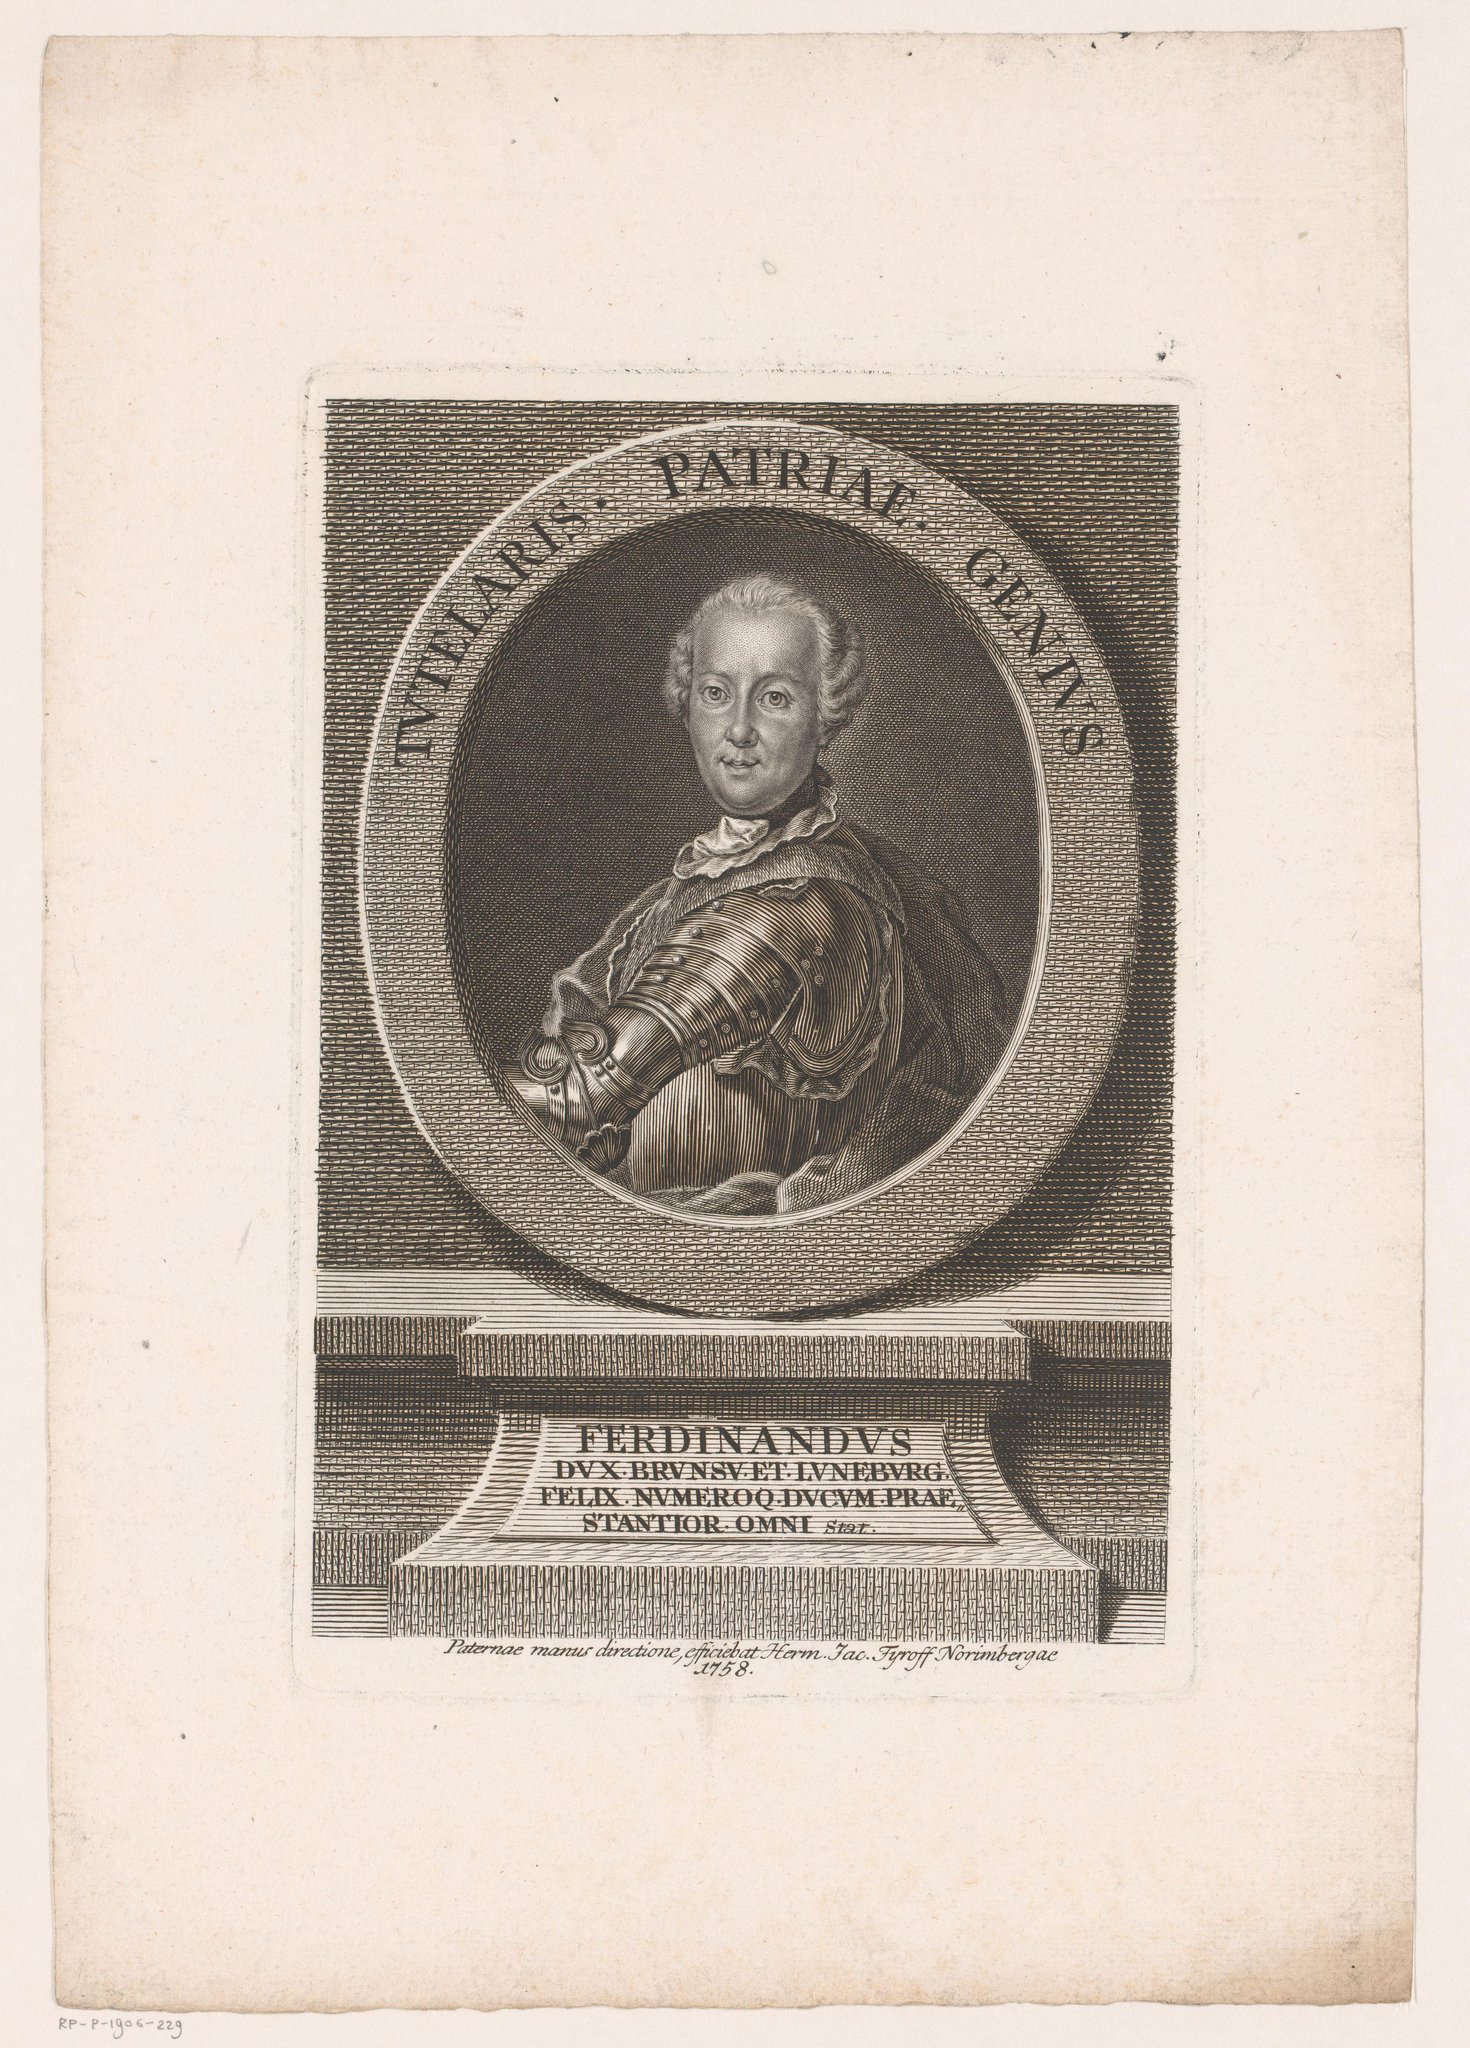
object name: print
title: Portret van Ferdinand hertog van Brunswijk-Wolfenbüttel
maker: hermann jakob tyroff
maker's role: print maker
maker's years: 1742-1809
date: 1758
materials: paper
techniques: engraving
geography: nuremberg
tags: armour, historical persons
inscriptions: collector's mark: Lugt 2228